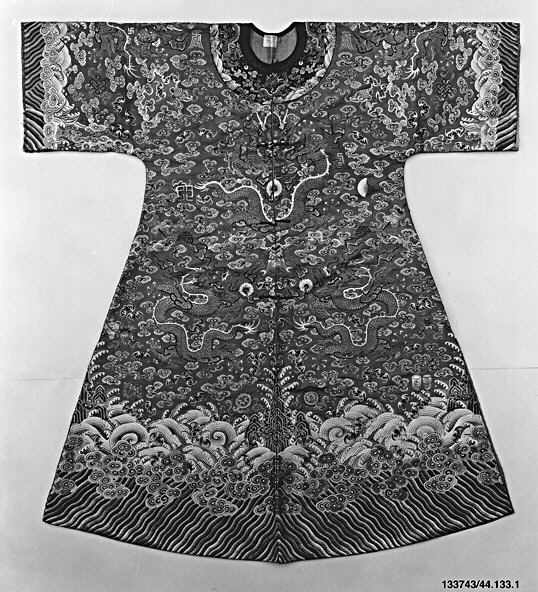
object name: coat, emperor's, 12 symbol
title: Emperor's Twelve-Symbol Coat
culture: chinese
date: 1723-1735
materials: metal thread, silk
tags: dragons